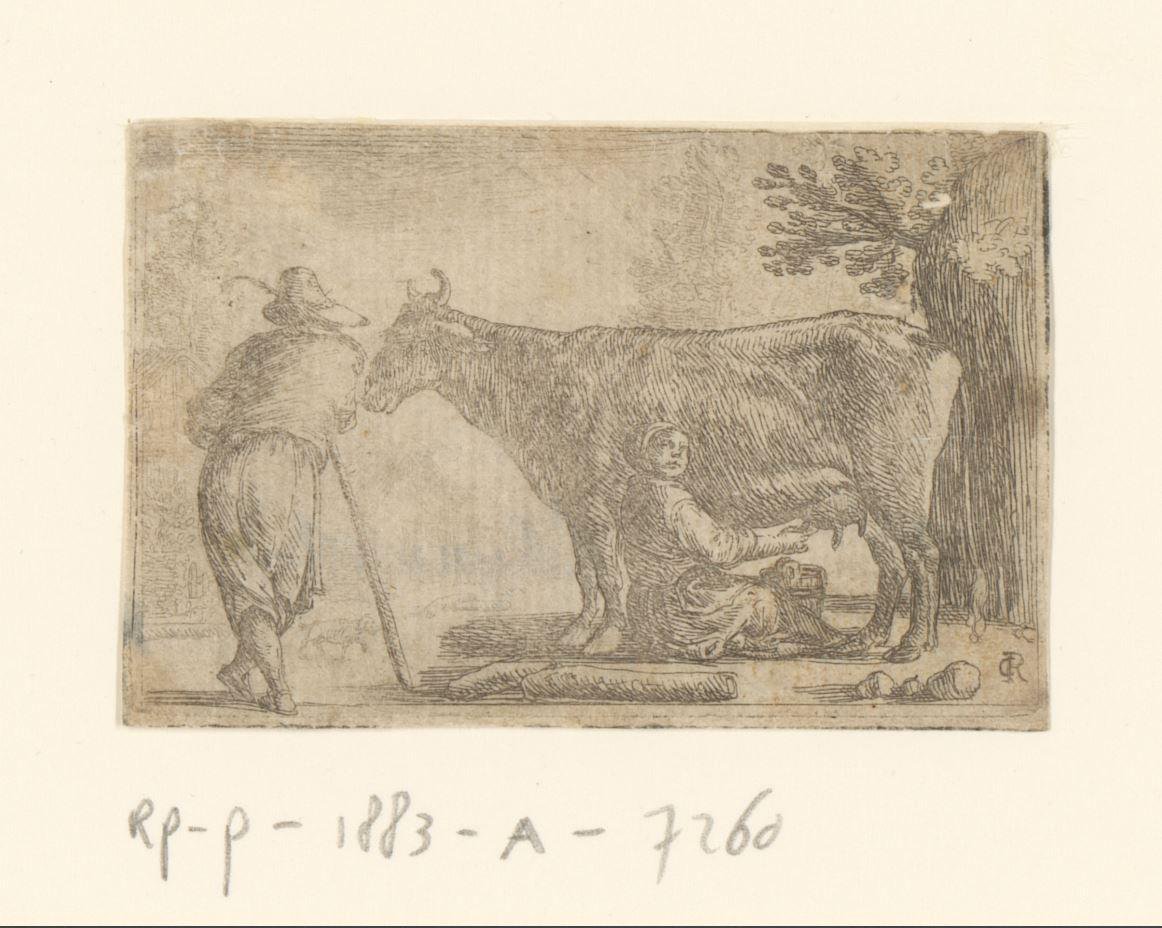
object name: print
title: Melkster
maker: christian richter (i)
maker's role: painter, print maker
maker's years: 1587-1667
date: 1599-1669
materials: paper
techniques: etching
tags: cow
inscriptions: collector's mark: Lugt 2228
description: Voor toeschrijving aan Richter zie: Jacoby, J. Niederdeutsche Beiträge zur Kunstgeschichte. Dl. 41 (2002), p. 202, noot 12.